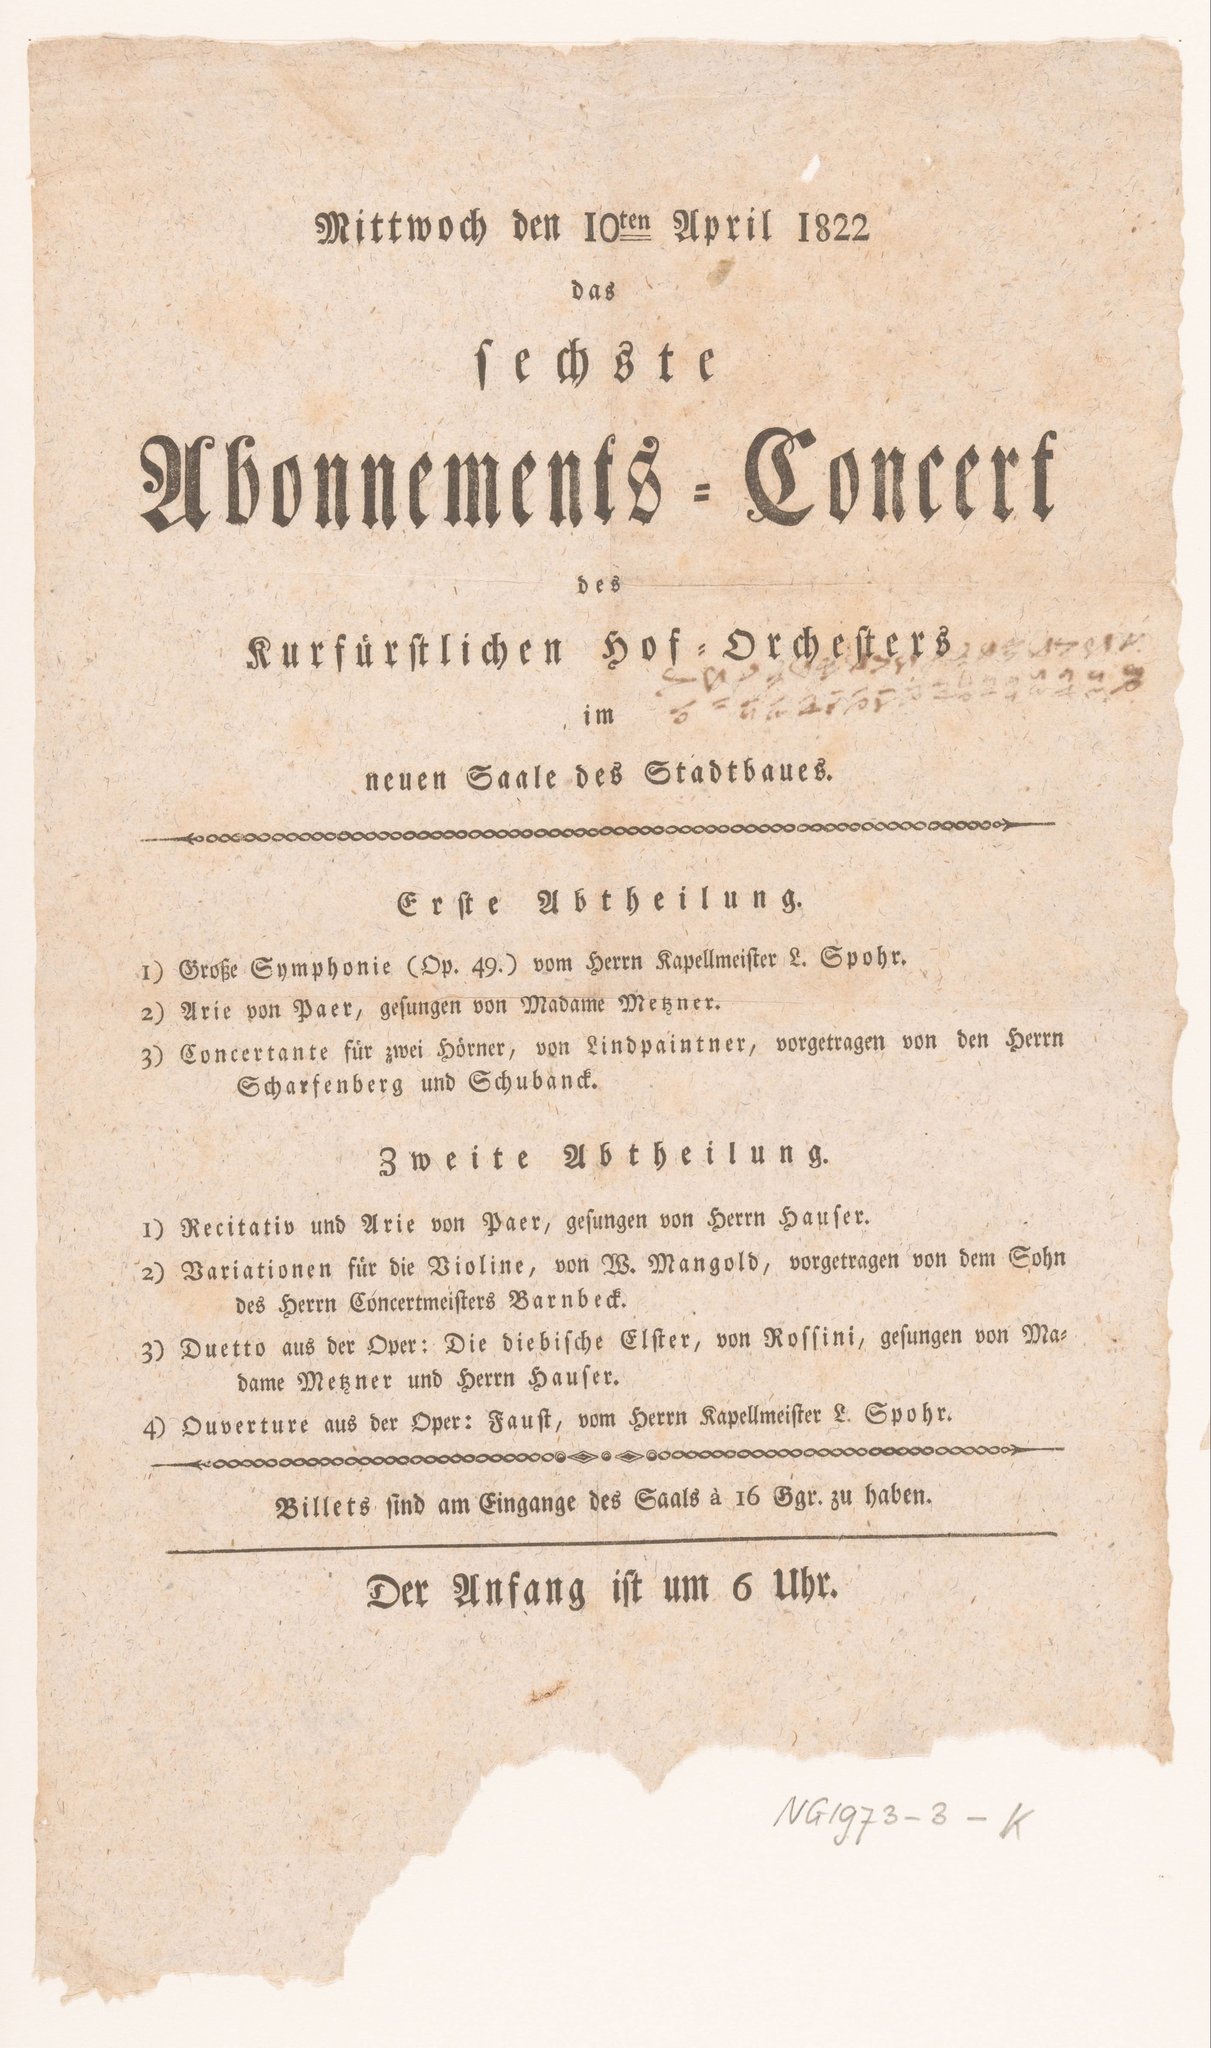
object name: document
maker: Anonymous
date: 1822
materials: ink, paper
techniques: printing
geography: germany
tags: the hague, johan rudolf thorbecke, germany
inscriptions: date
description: Aankondiging concert 10 sept. 1822 te (?). Onderzijde afgescheurd.